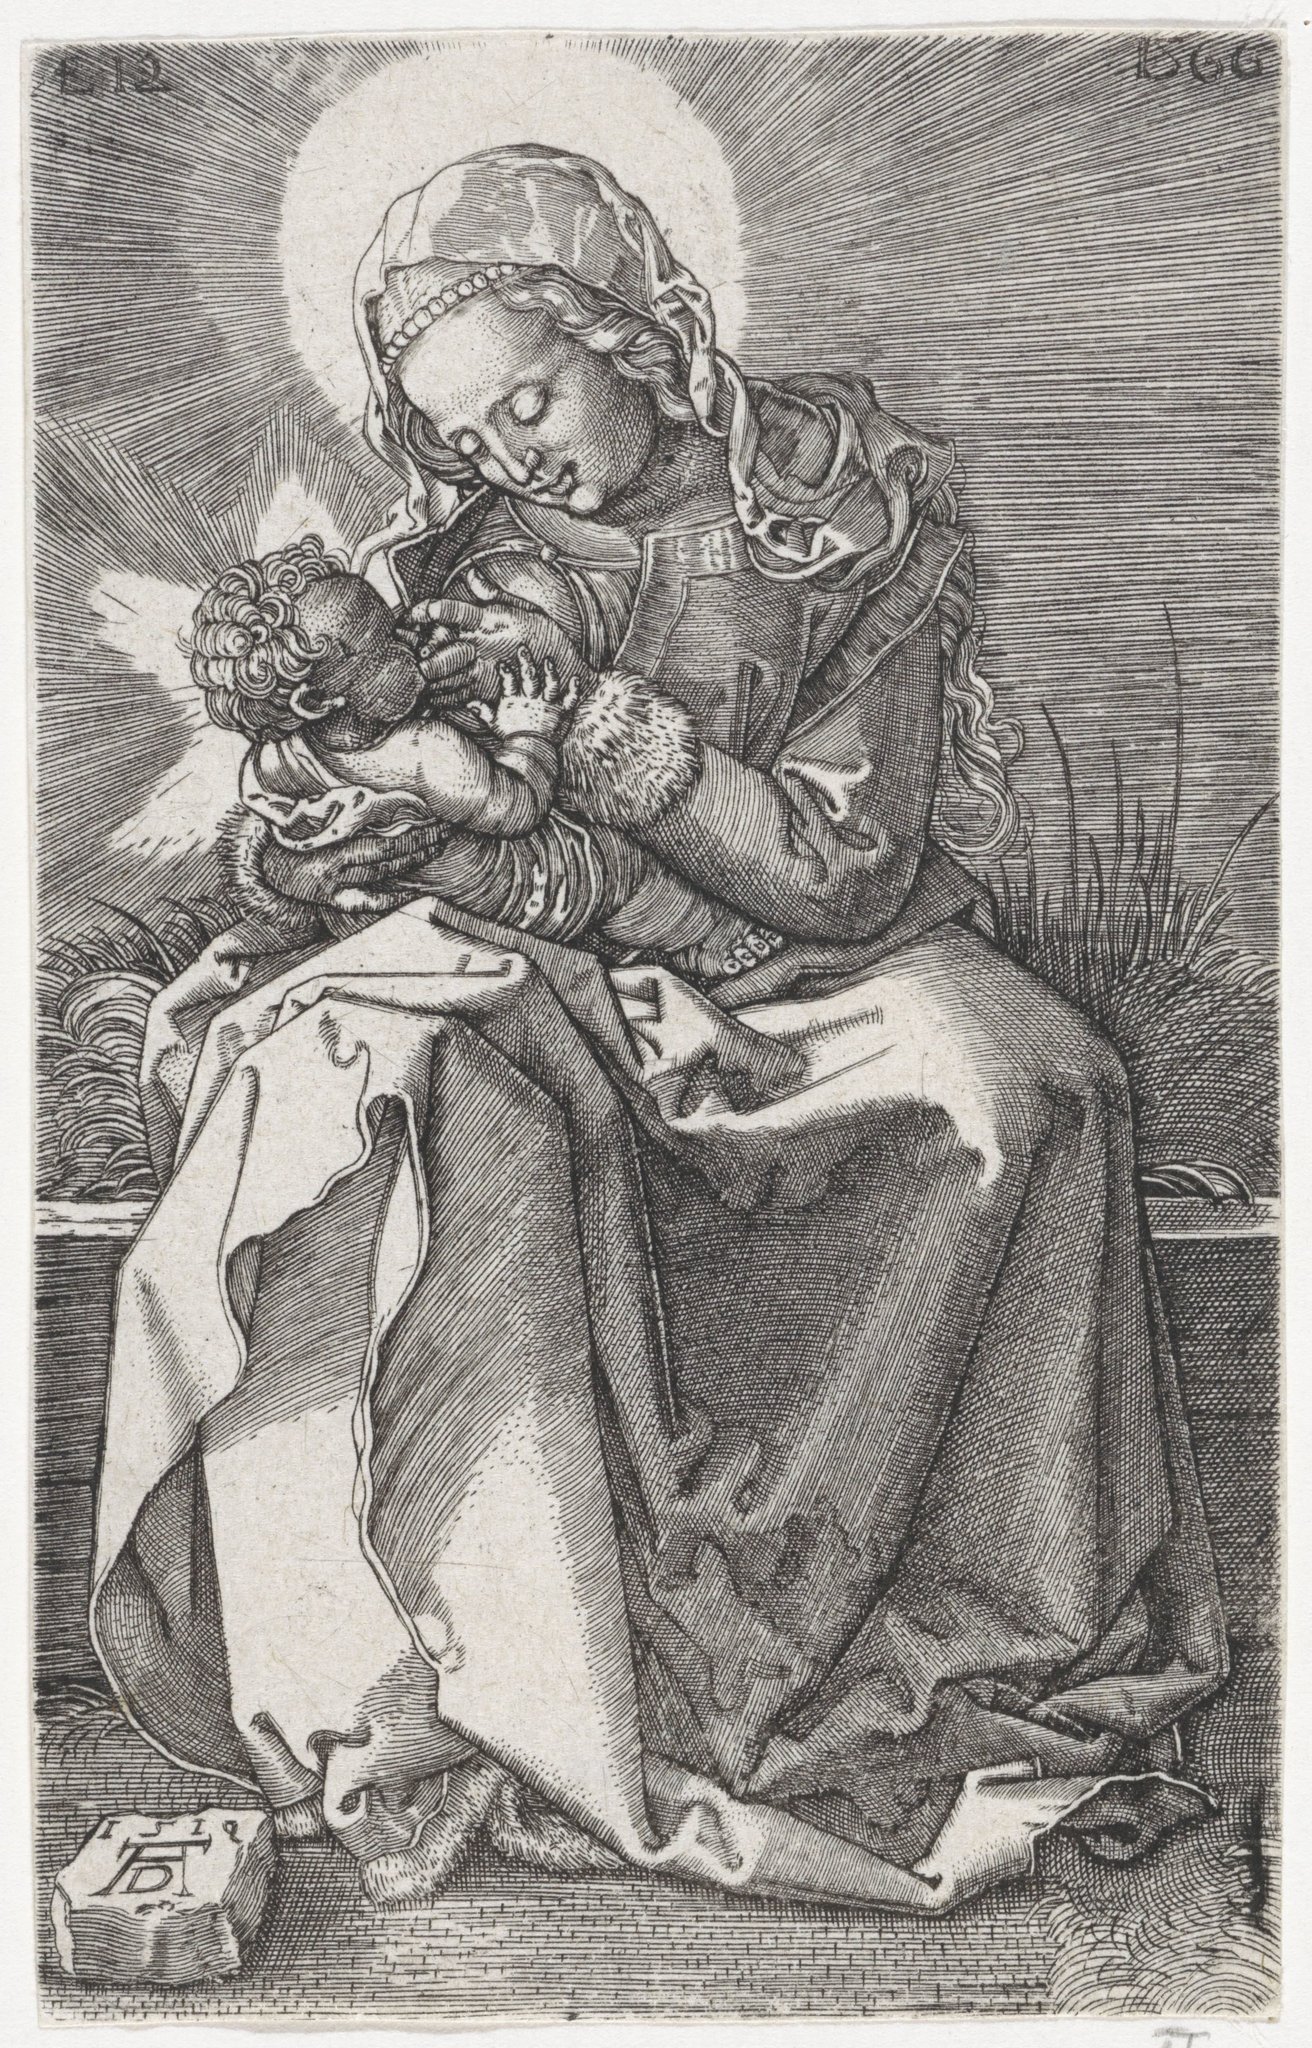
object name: print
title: Maria zoogt het Christuskind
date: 1566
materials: paper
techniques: engraving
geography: antwerp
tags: christ-child suckling, or beginning to suckle, e.g. mary uncovering her breast ~ madonna-representations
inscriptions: collector's mark: Lugt 2228, collector's mark: Lugt 2760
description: Maria zit op een muurtje en zoogt het Christuskind. Aan haar voeten ligt een steen met het monogram van Albrecht Dürer en de datering van diens prent: 1519. Linksboven gemarkeerd: Æ 12.